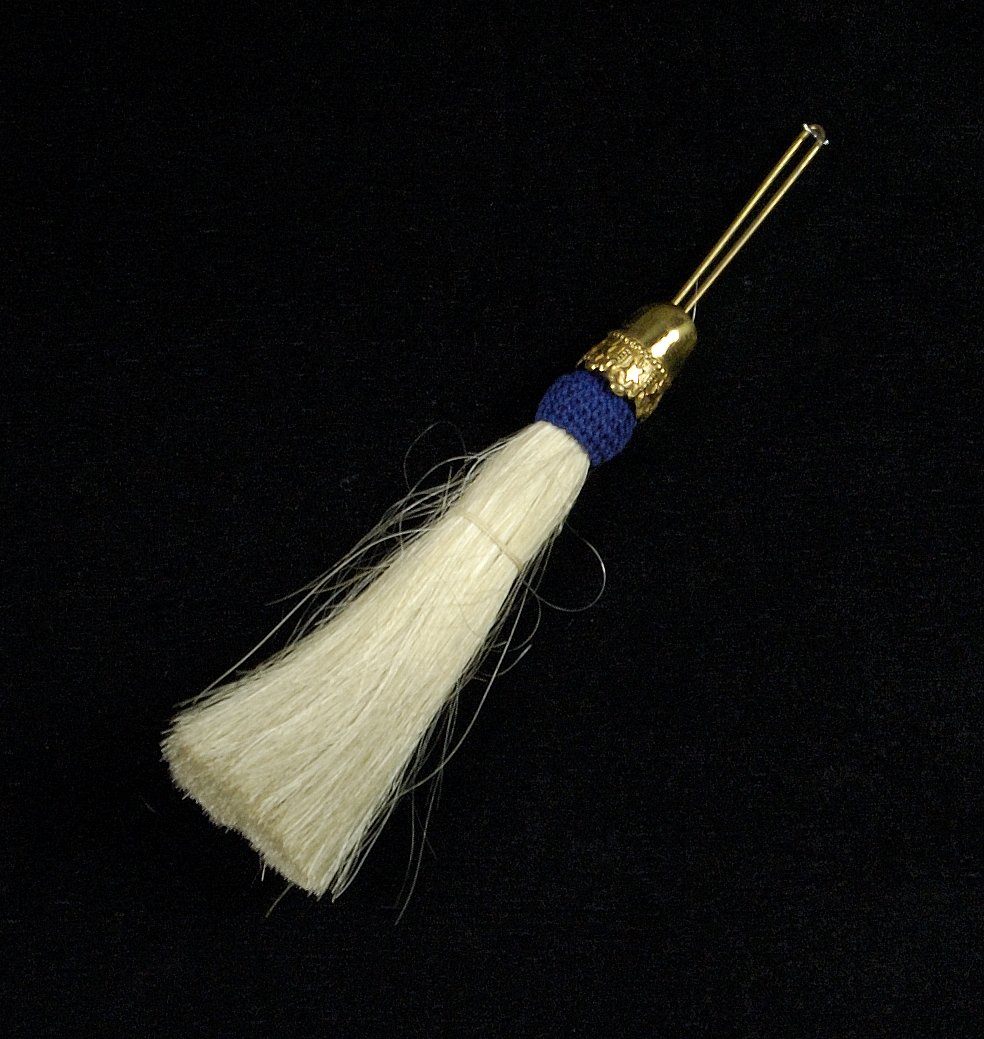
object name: brush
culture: american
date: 1875-1880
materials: hair, metal, wool